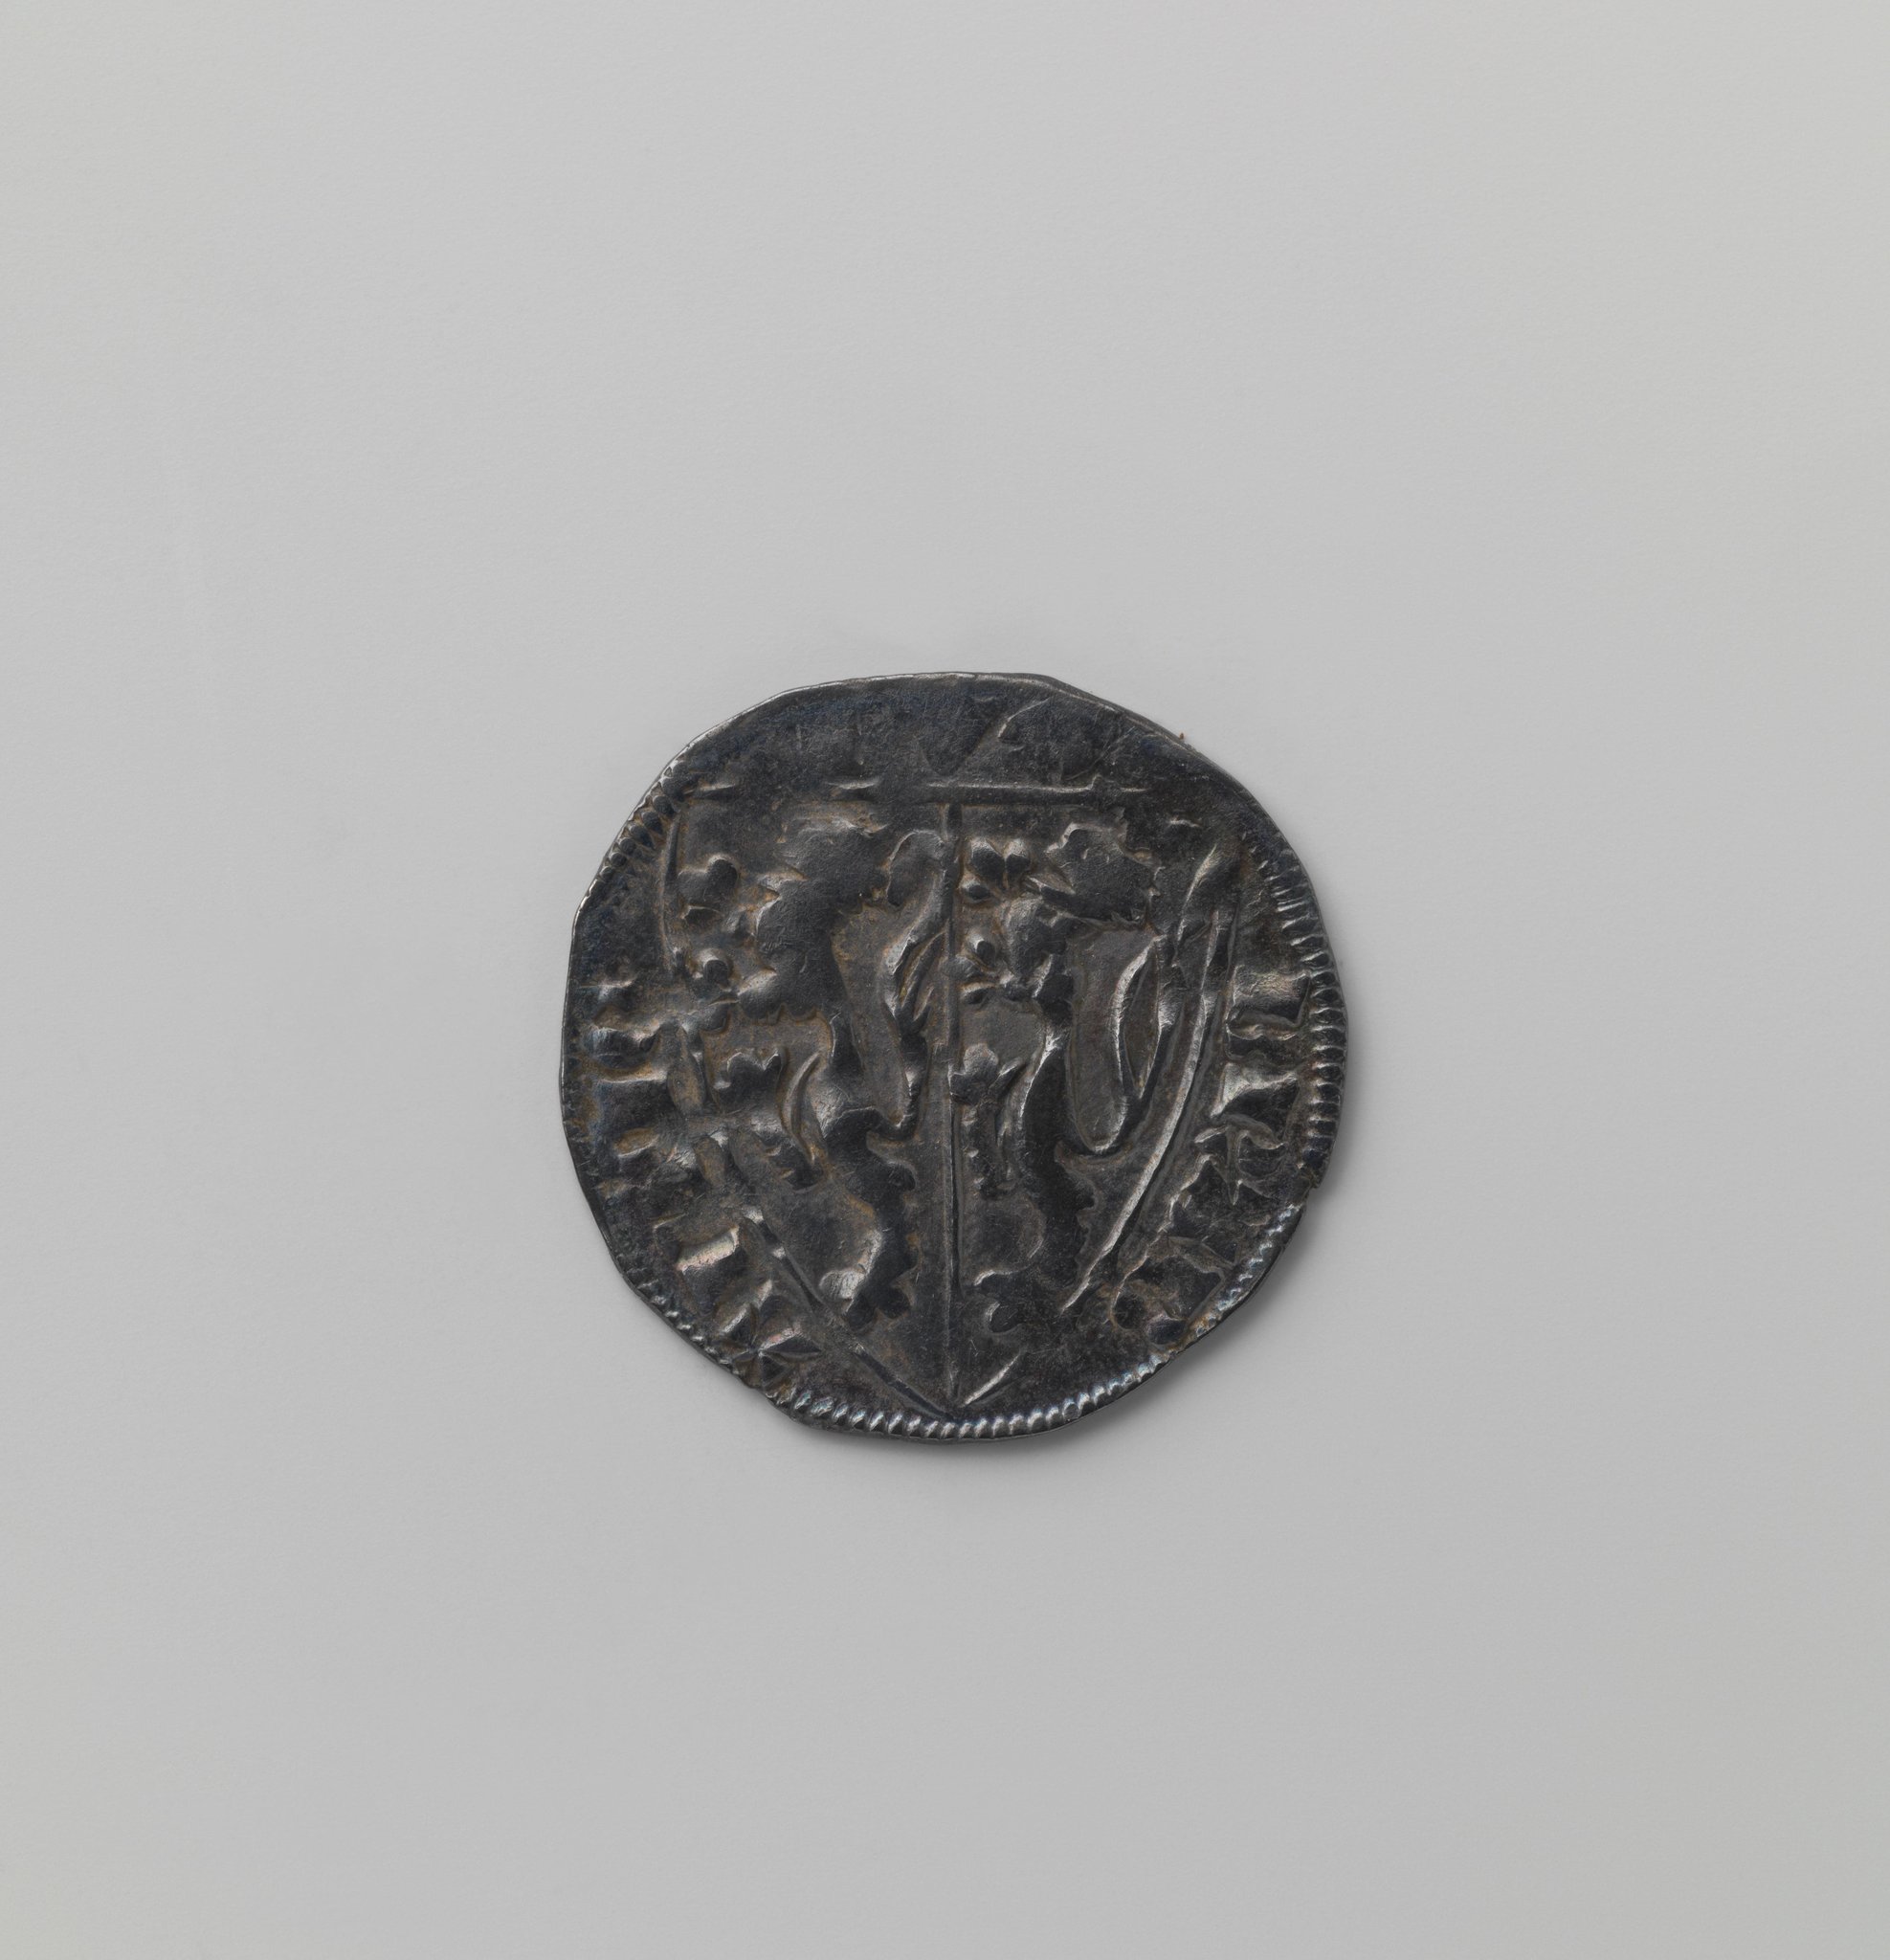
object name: coin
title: Brabant, Jan II, sterling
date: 1309-1312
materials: silver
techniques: striking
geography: antwerp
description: Voorzijde: in een punt uitlopend gecombineerd Brabants/Limburgs wapenschild, waaromheen omschrift. Keerzijde: lang kruis, in de hoeken drie bolletjes. Daaromheen omschrift MON-ETA-ANT-WP'